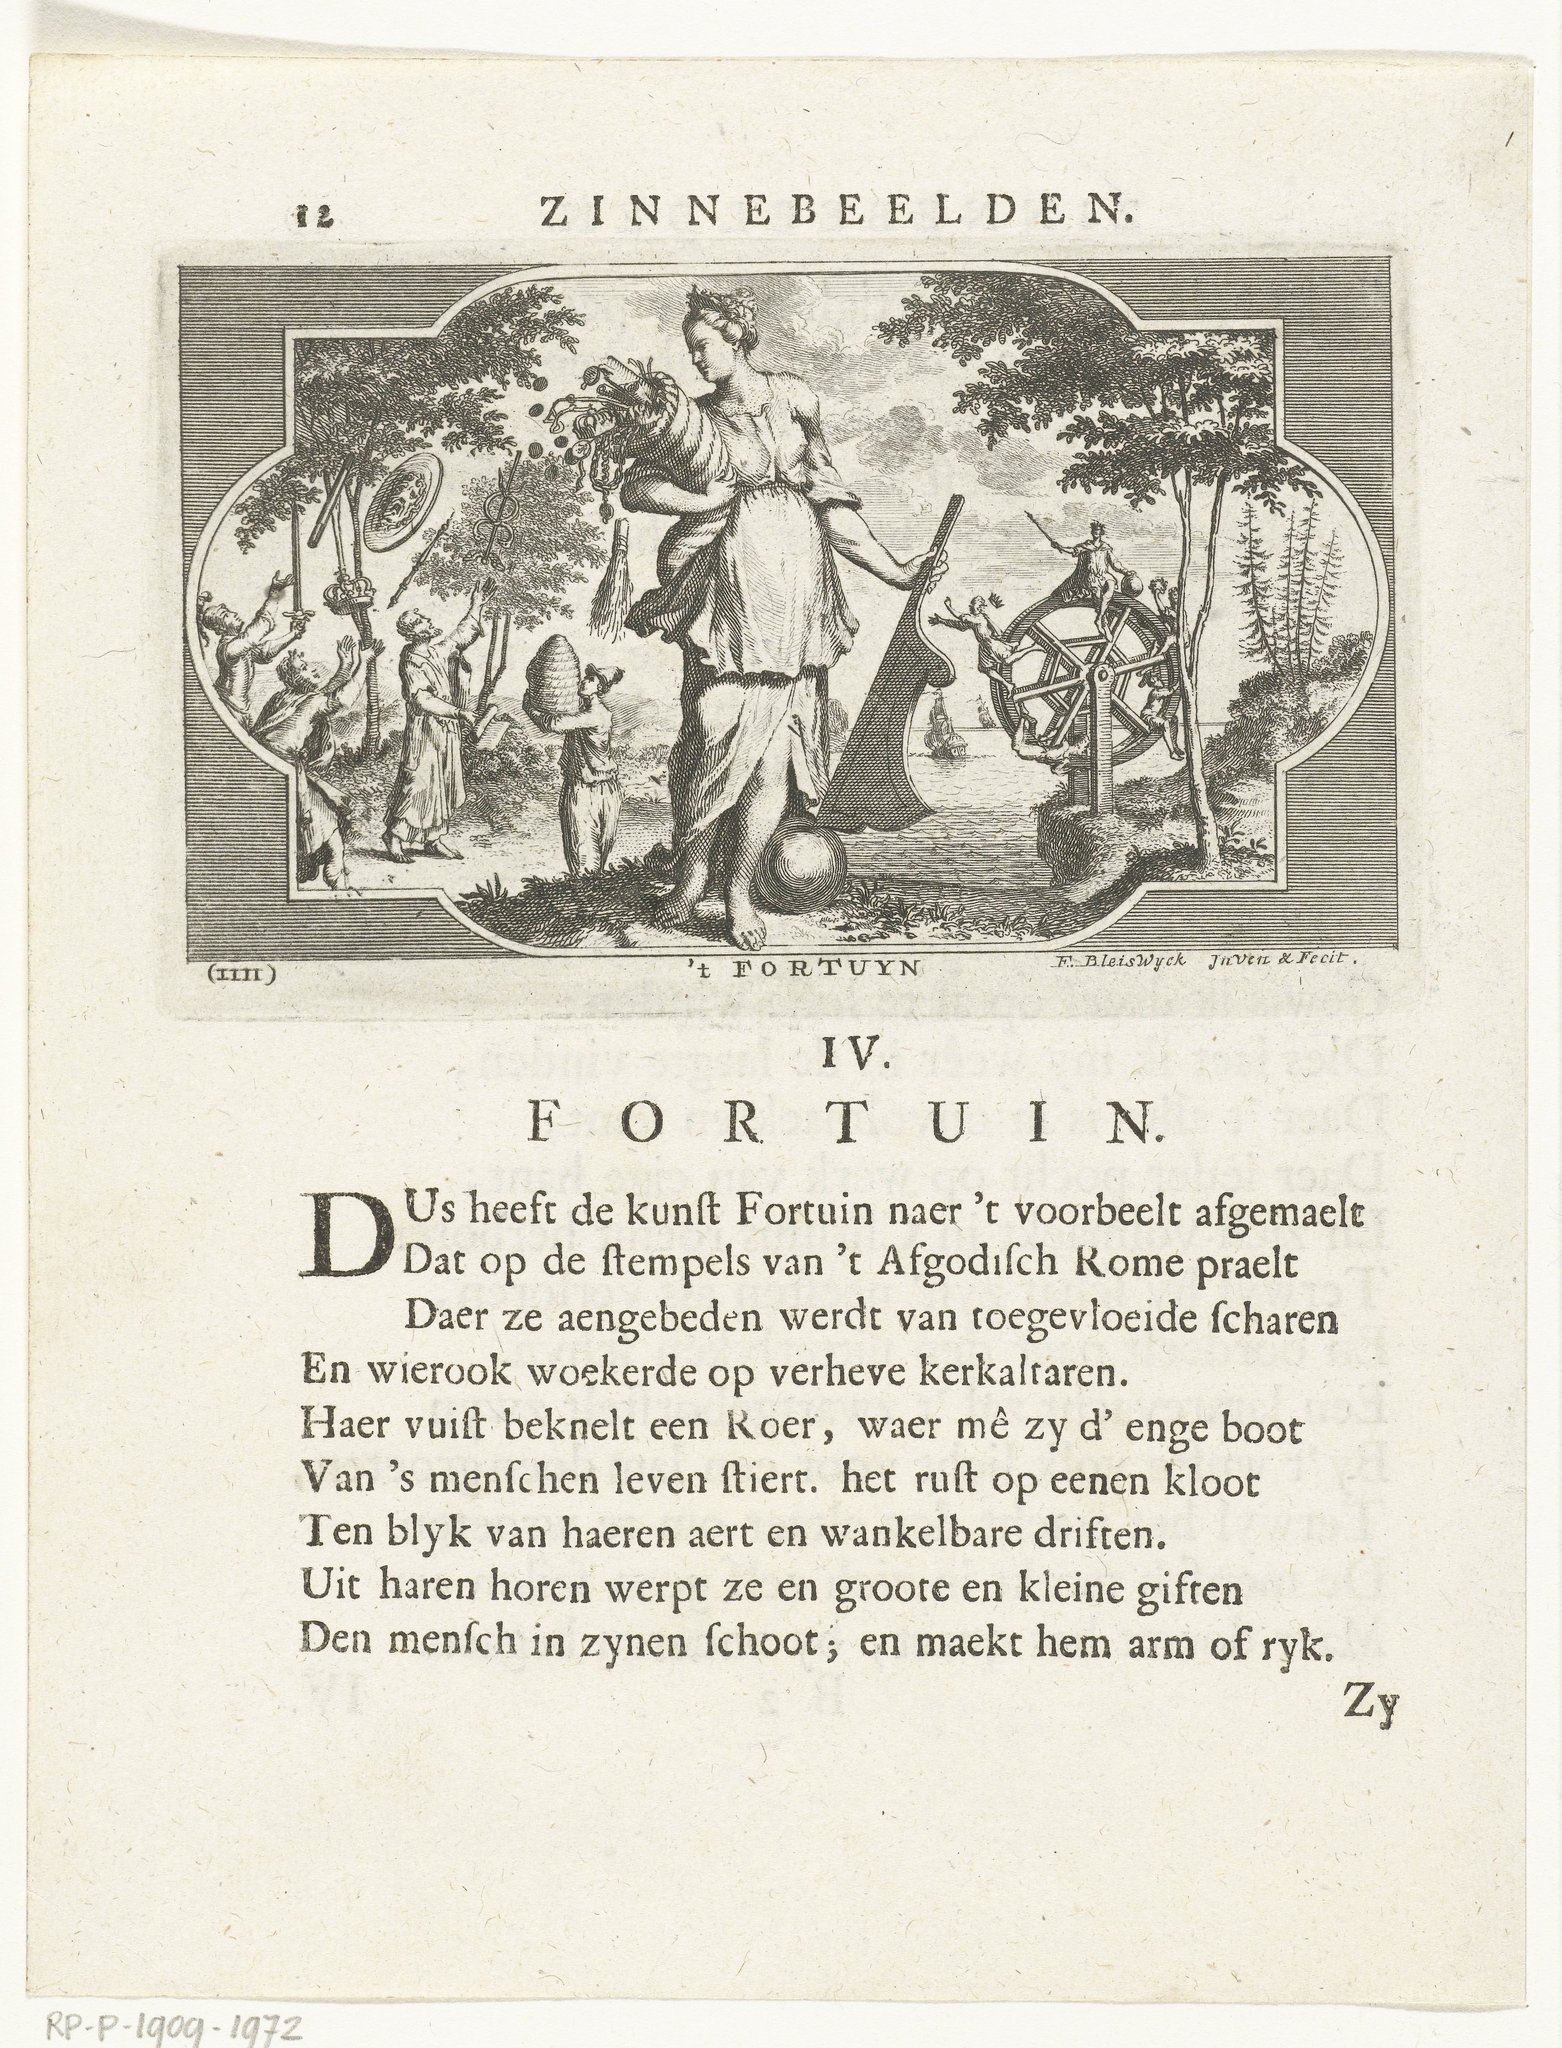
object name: book illustration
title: 't Fortuyn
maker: françois van bleyswijck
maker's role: draughtsman, print maker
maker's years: 1671-1746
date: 1681-1737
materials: paper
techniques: etching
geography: leiden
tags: fortuna as roman personification, luck, fortune, lot; 'fato', 'fortuna', 'fortuna aurea', 'fortuna buona', 'fortuna pacifica overo clemente', 'sorte' (ripa), abstract ideas and concepts (+ emblematical representation of concept)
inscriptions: collector's mark: Lugt 2228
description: Embleem met allegorie op fortuin verbeeld door vrouw met roer en hoorn des overvloeds. In het landschap zitten (onfortuinlijke) figuren op het rad van fortuin en mannen vangen attributen uit de lucht die staan voor macht zoals een kroon, scepter, caduceus en bijenkorf. Onder de voorstelling en op het verso staat een gedicht.